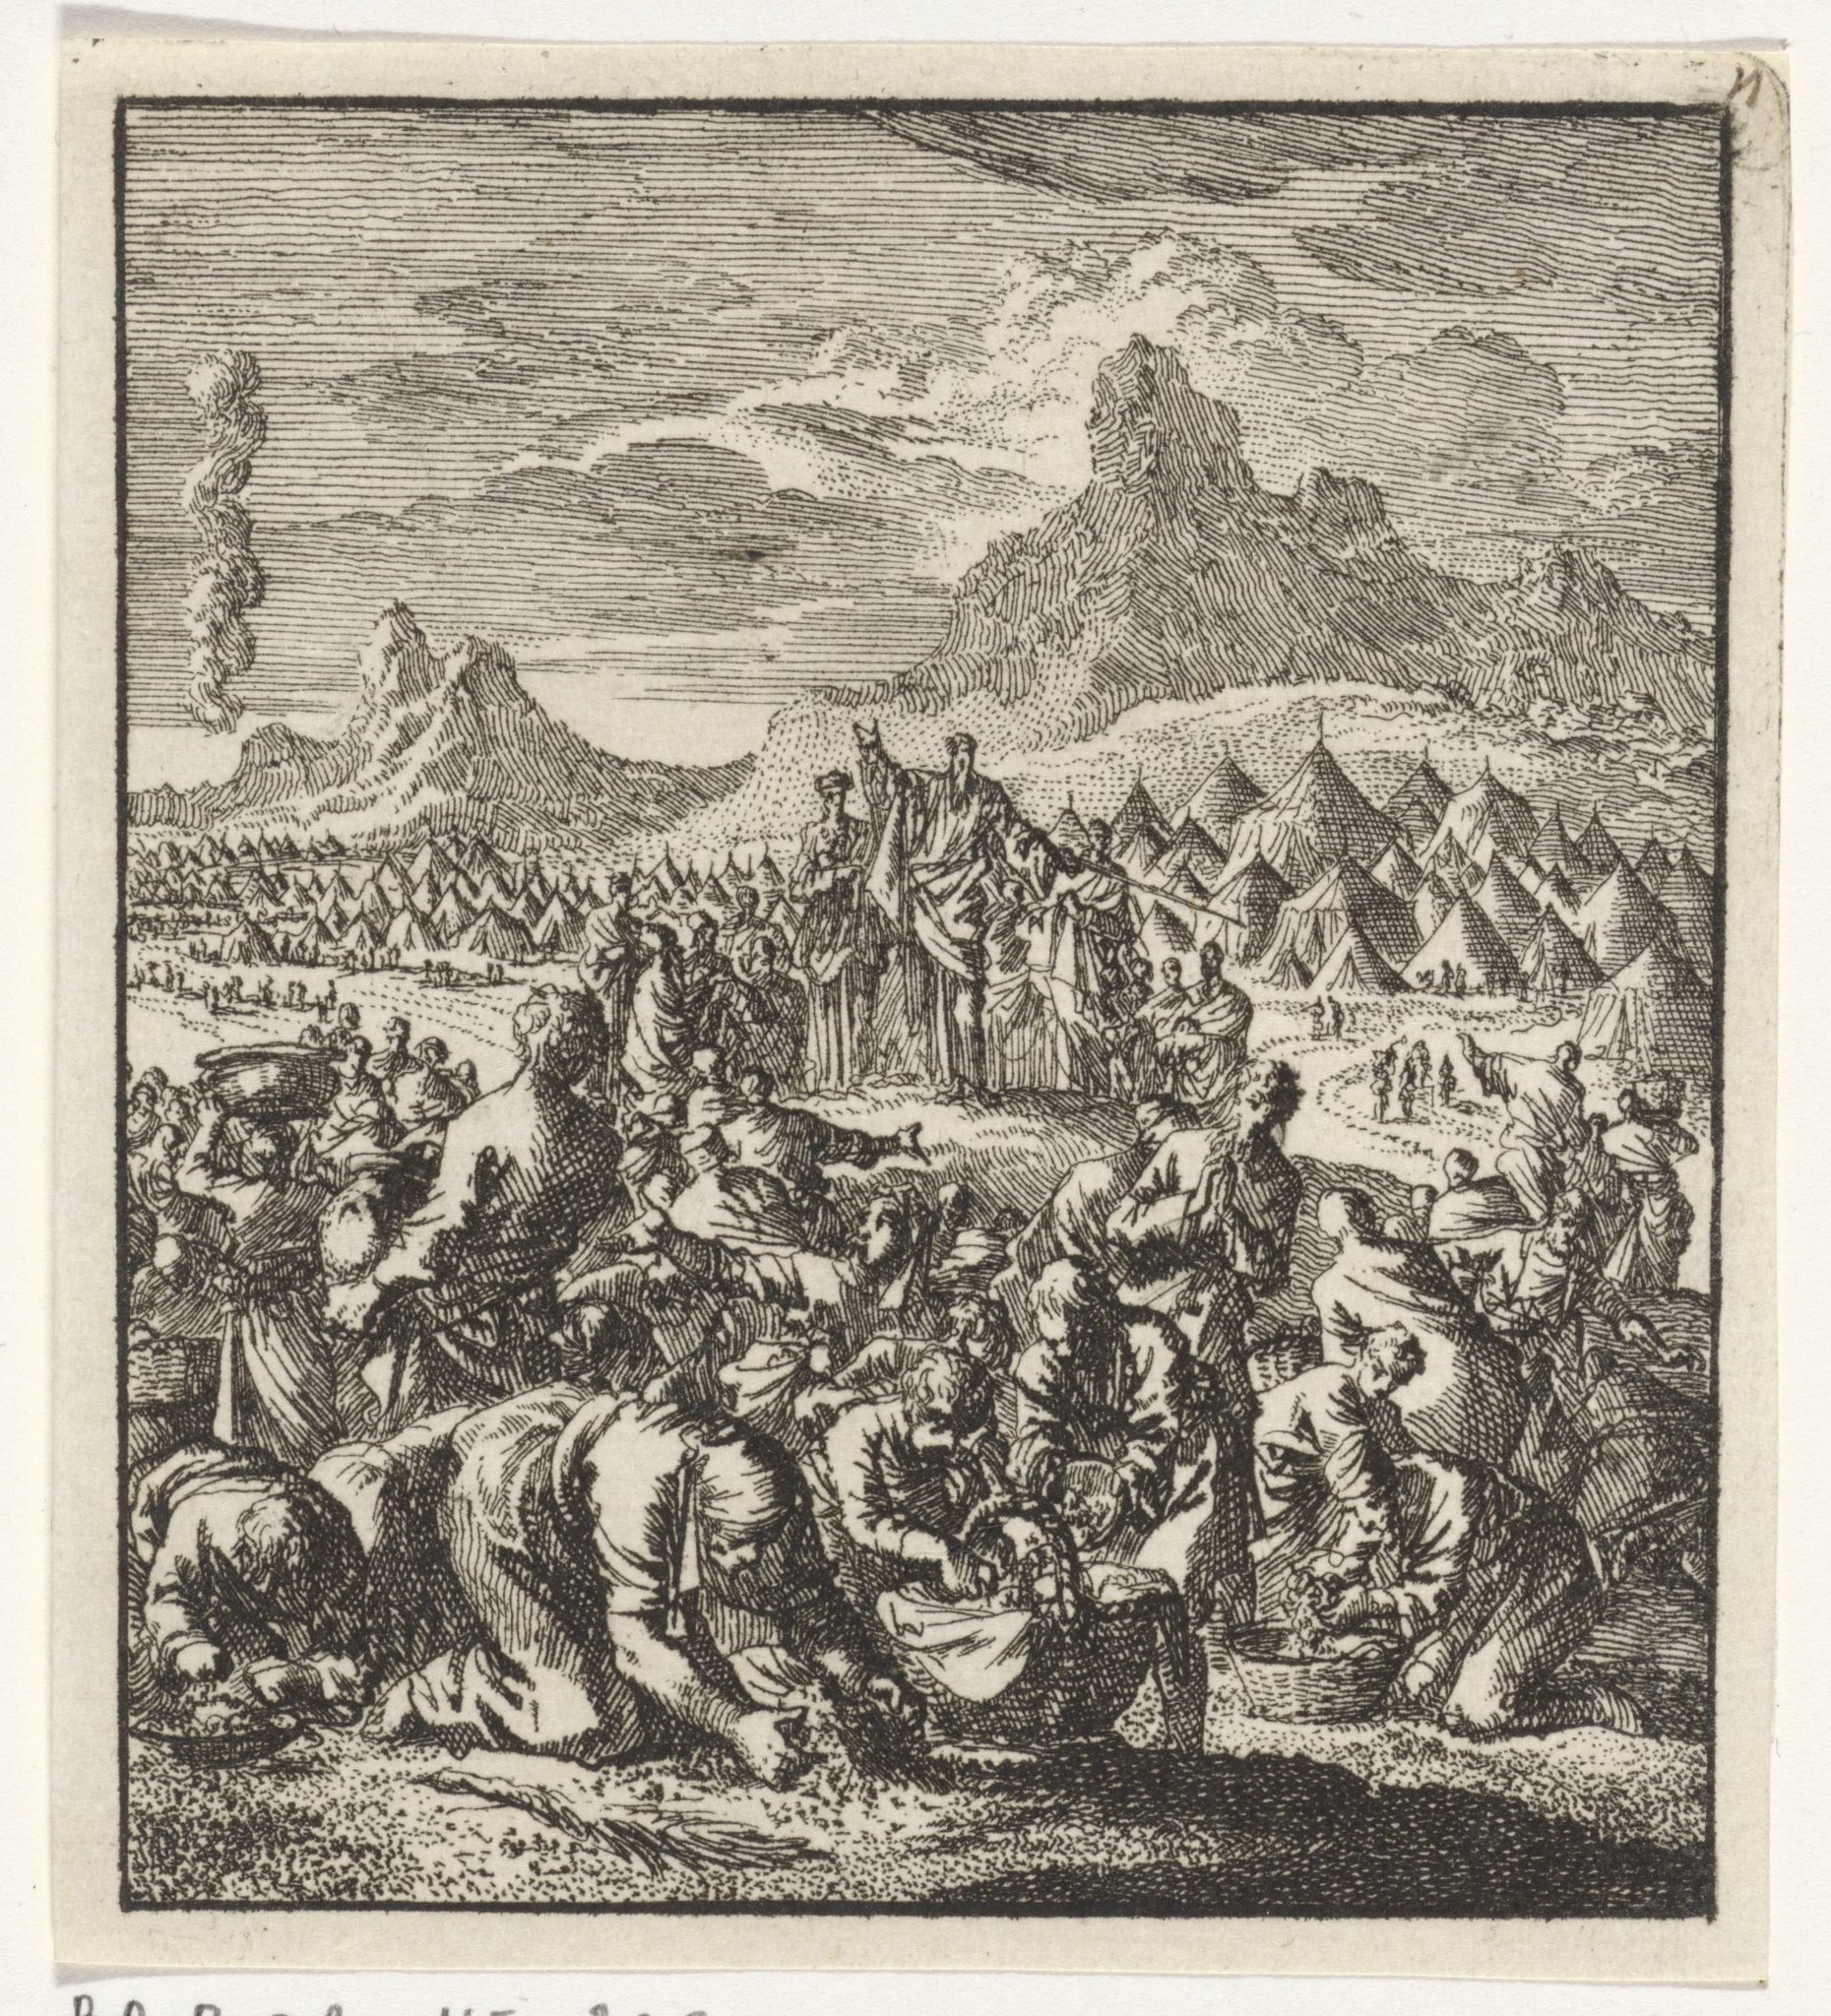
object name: book illustration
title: Inzameling van het manna door de Israëlieten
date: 1706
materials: paper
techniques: etching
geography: amsterdam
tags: the gathering of manna (in baskets and pots)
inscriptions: collector's mark: Lugt 2228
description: Illustratie voor: Schabaalje, Jean Philipsz. De vermeerderde lust-hof des gemoeds. Amsterdam: Jan Rieuwertsz. (II) en Barent Visscher, 1706, p. 211.